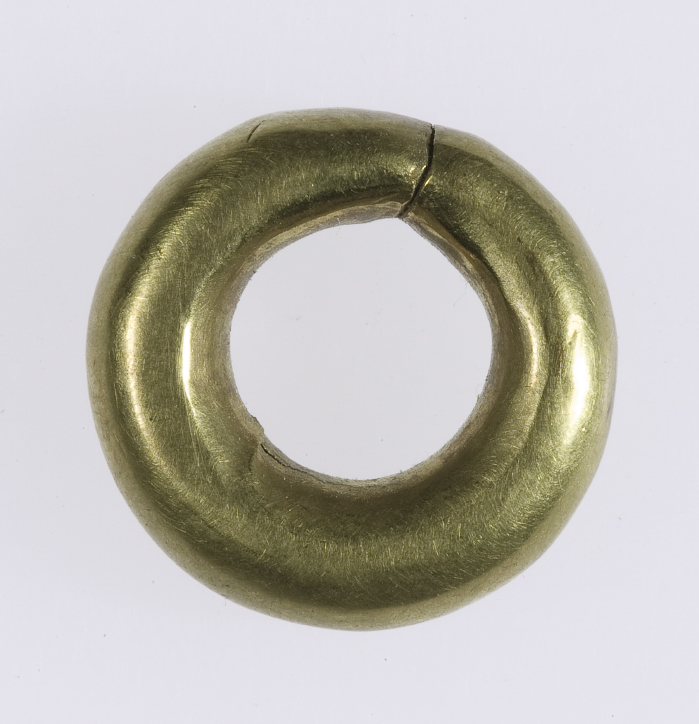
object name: earring, penannular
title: Penannular Earring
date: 1550-1425 BCE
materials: gold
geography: egypt